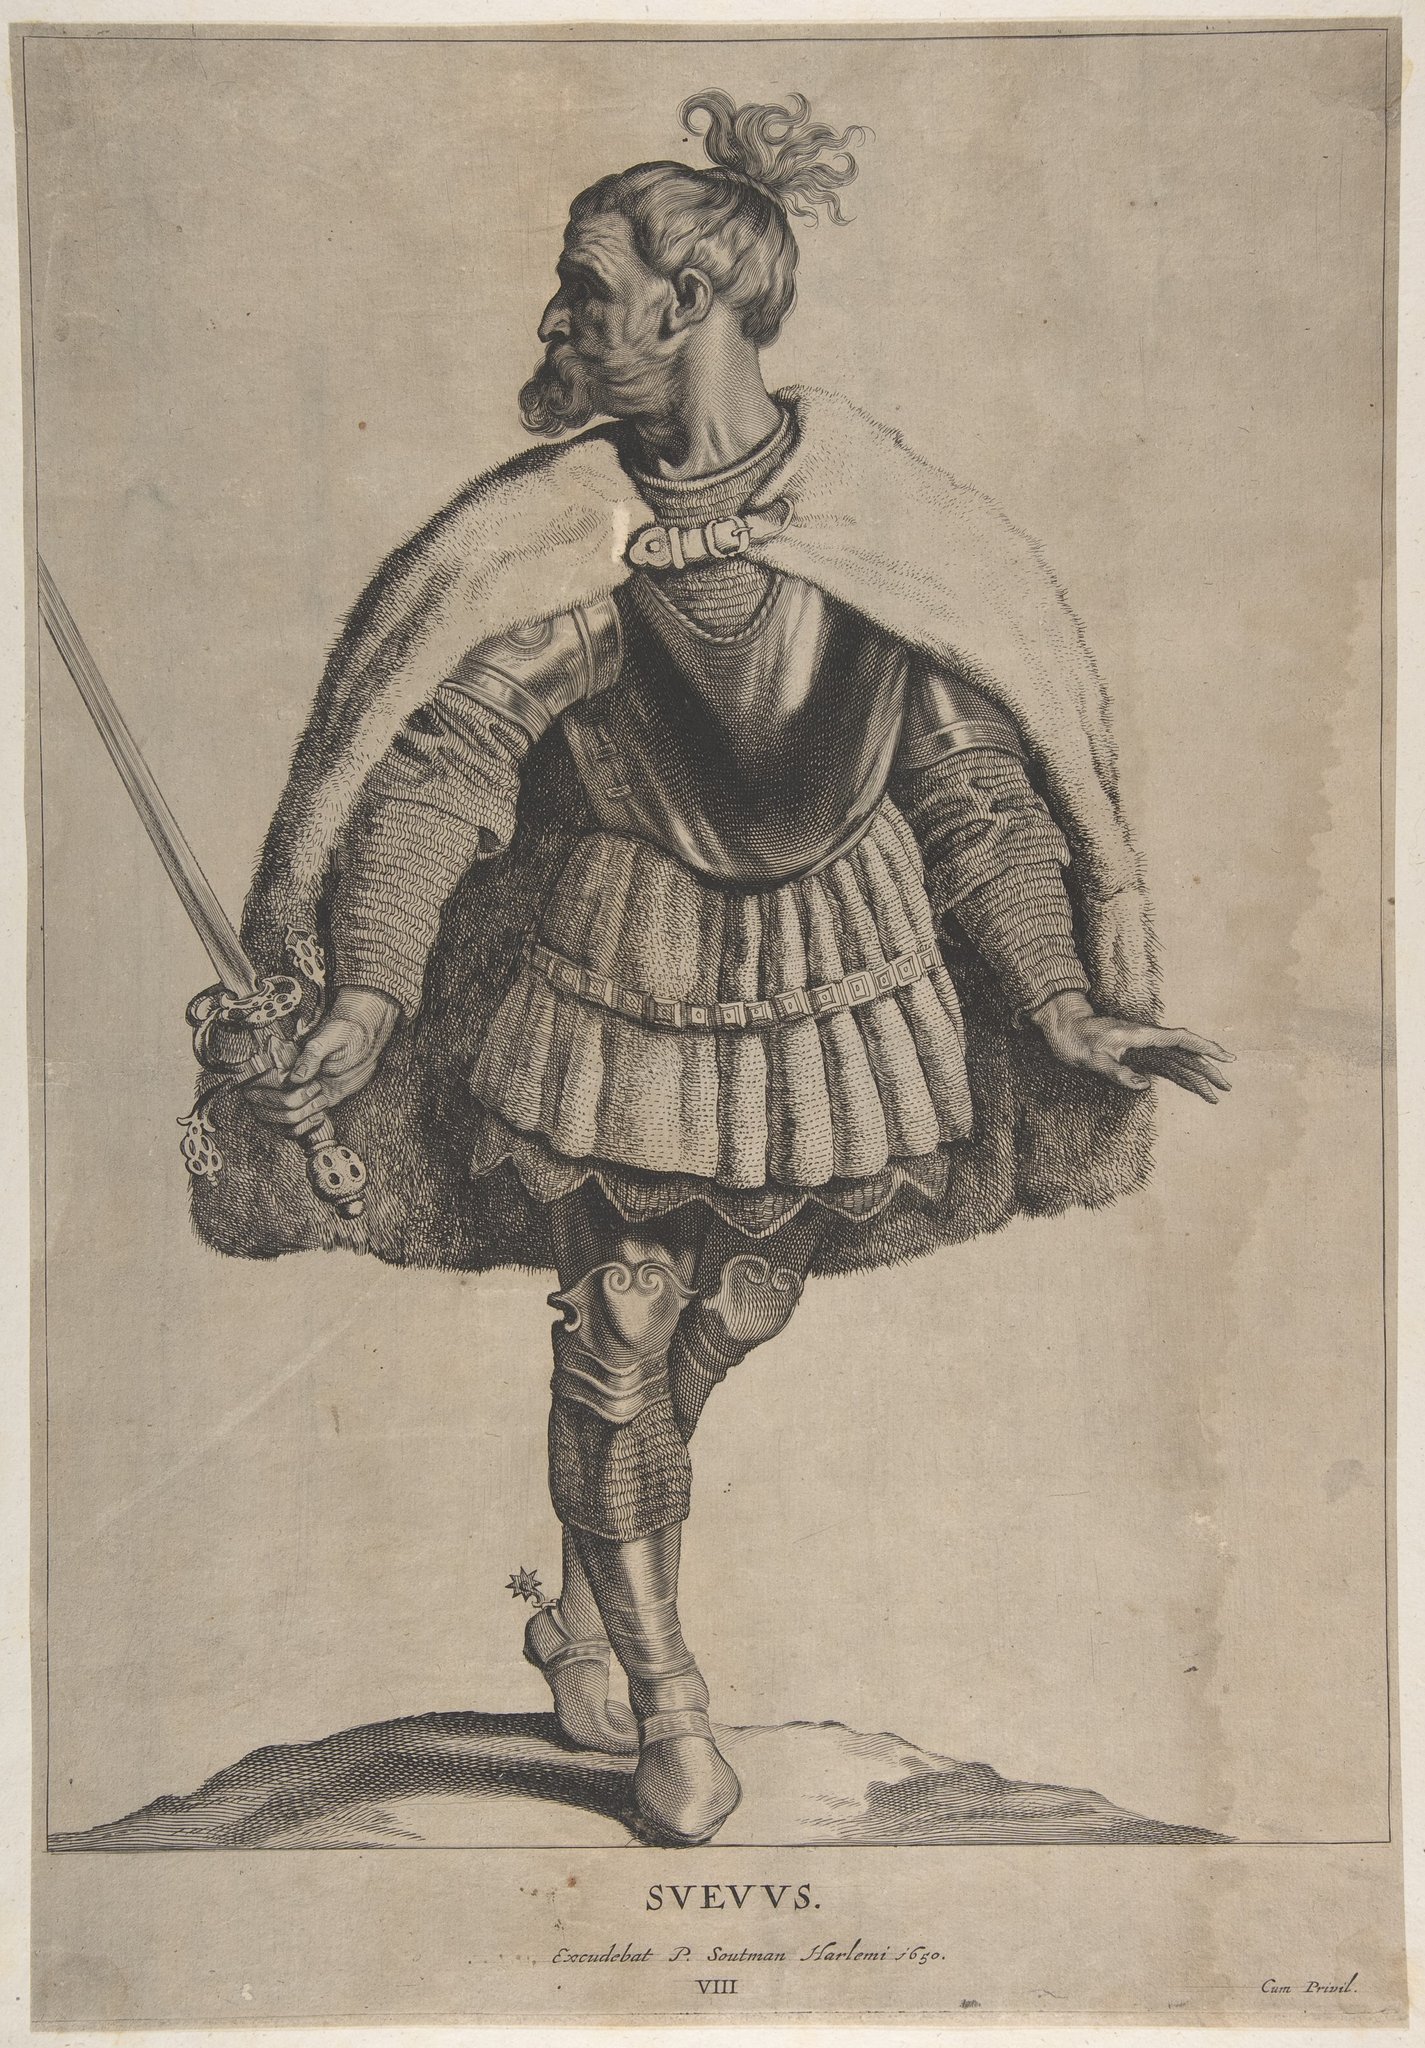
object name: print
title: Svevus, from the series Peplus, sive Gothorum, Heruolorum...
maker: pieter soutman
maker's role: artist and publisher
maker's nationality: dutch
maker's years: 1580-1657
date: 1650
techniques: engraving, etching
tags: swords,men